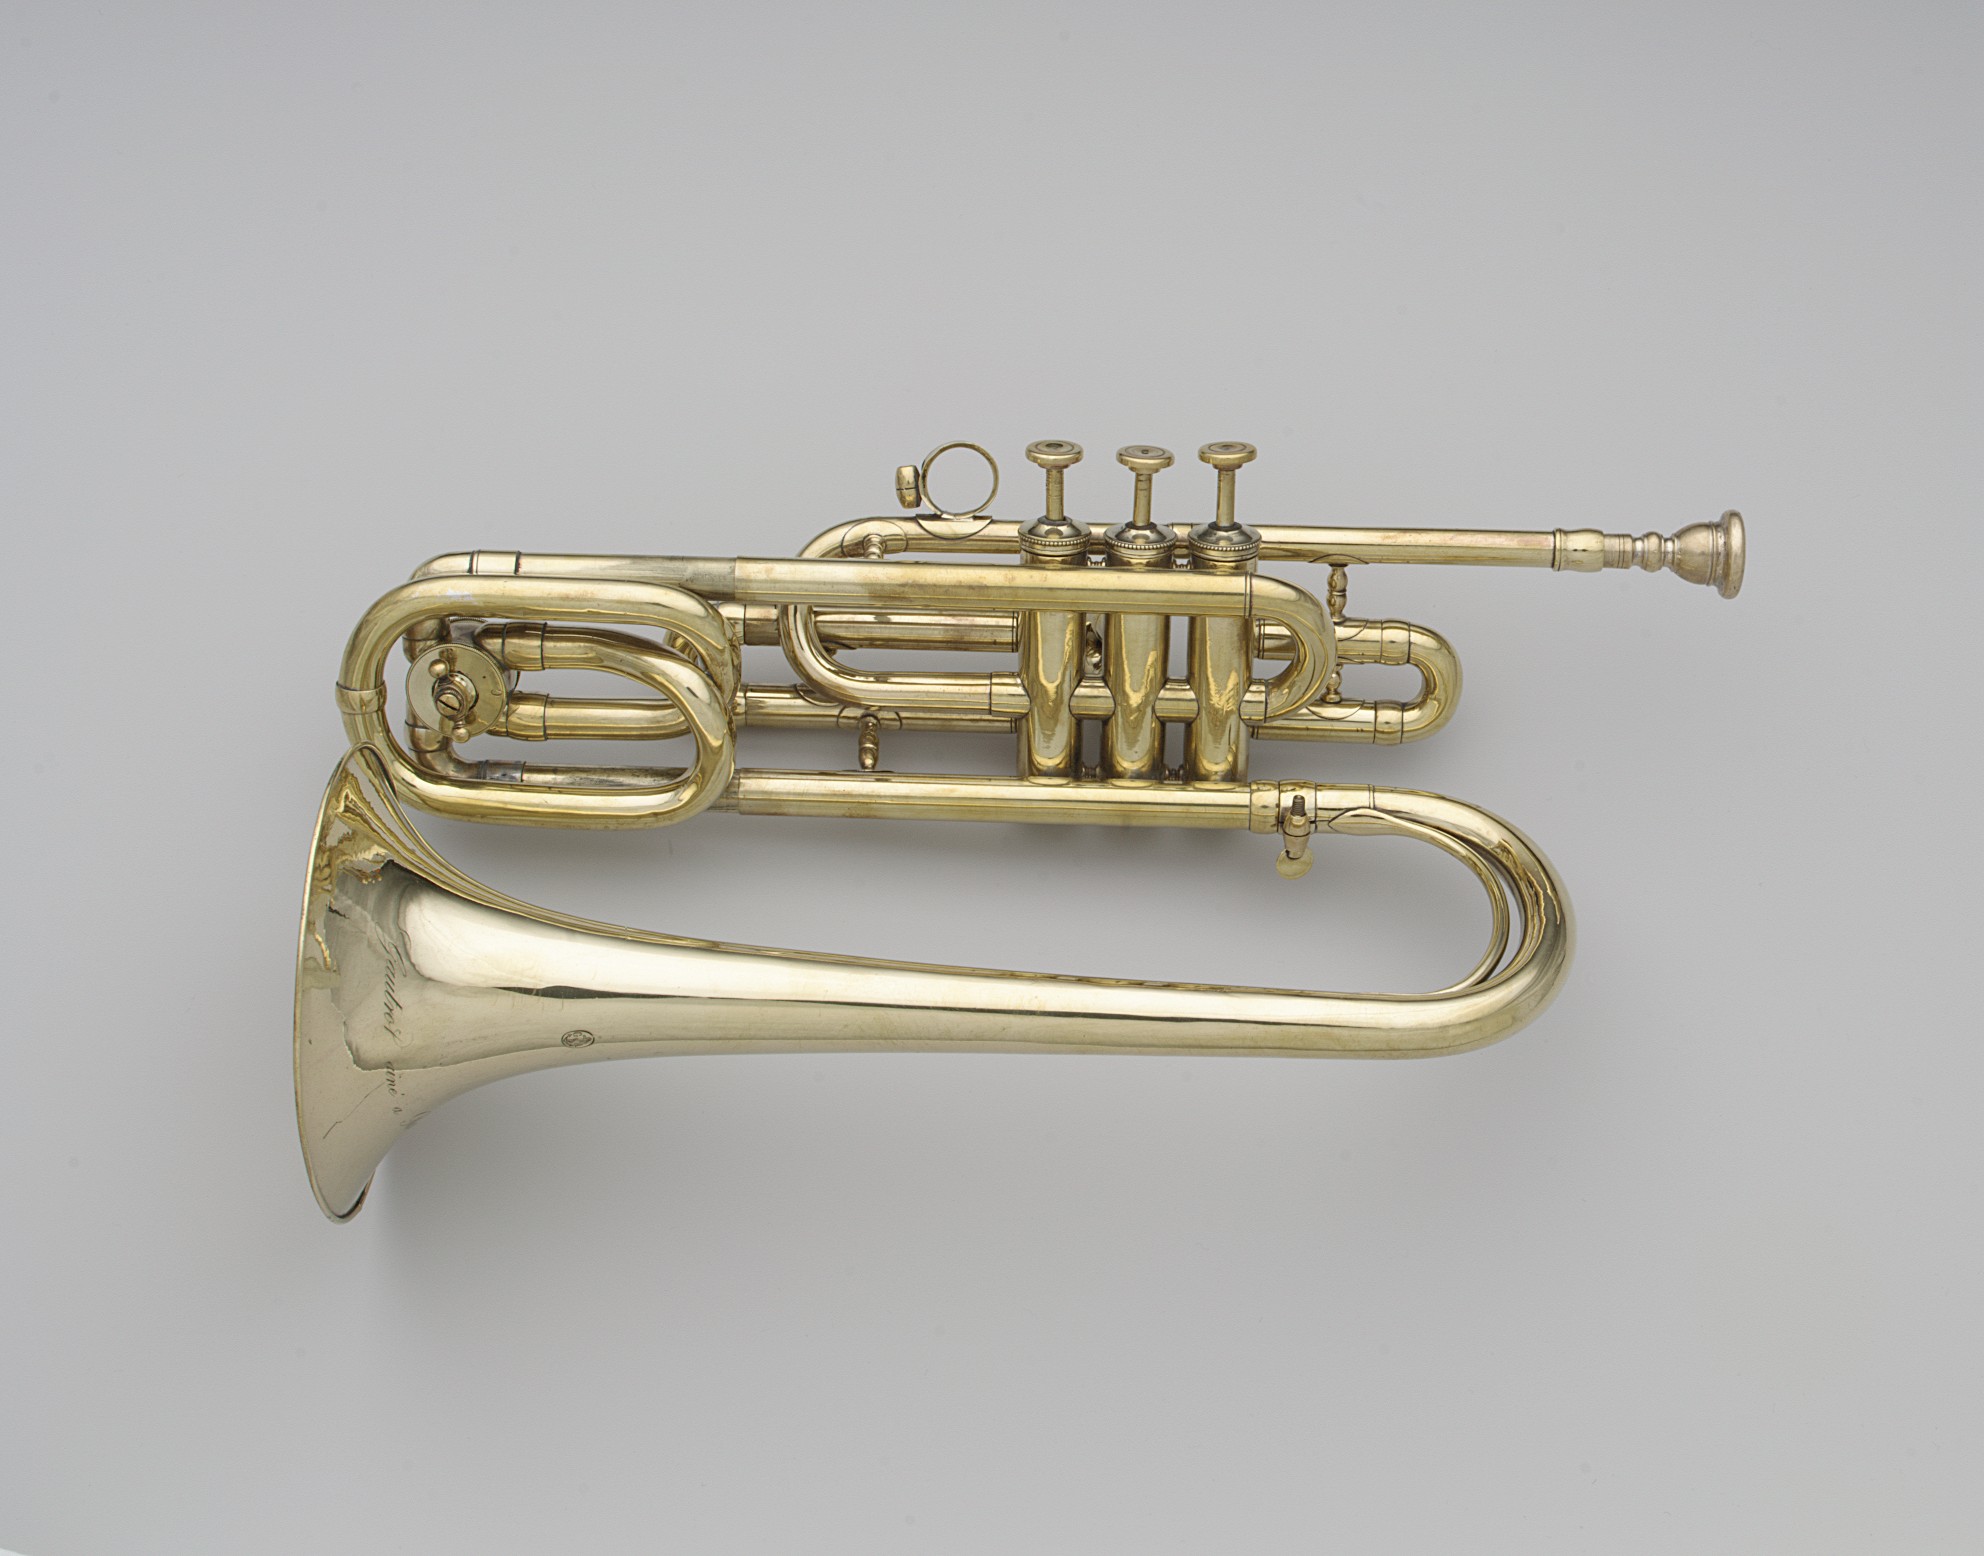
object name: cornet omnitonique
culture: french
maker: gautrot aîné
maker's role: maker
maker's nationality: french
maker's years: 1870-1884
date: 1847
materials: brass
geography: france